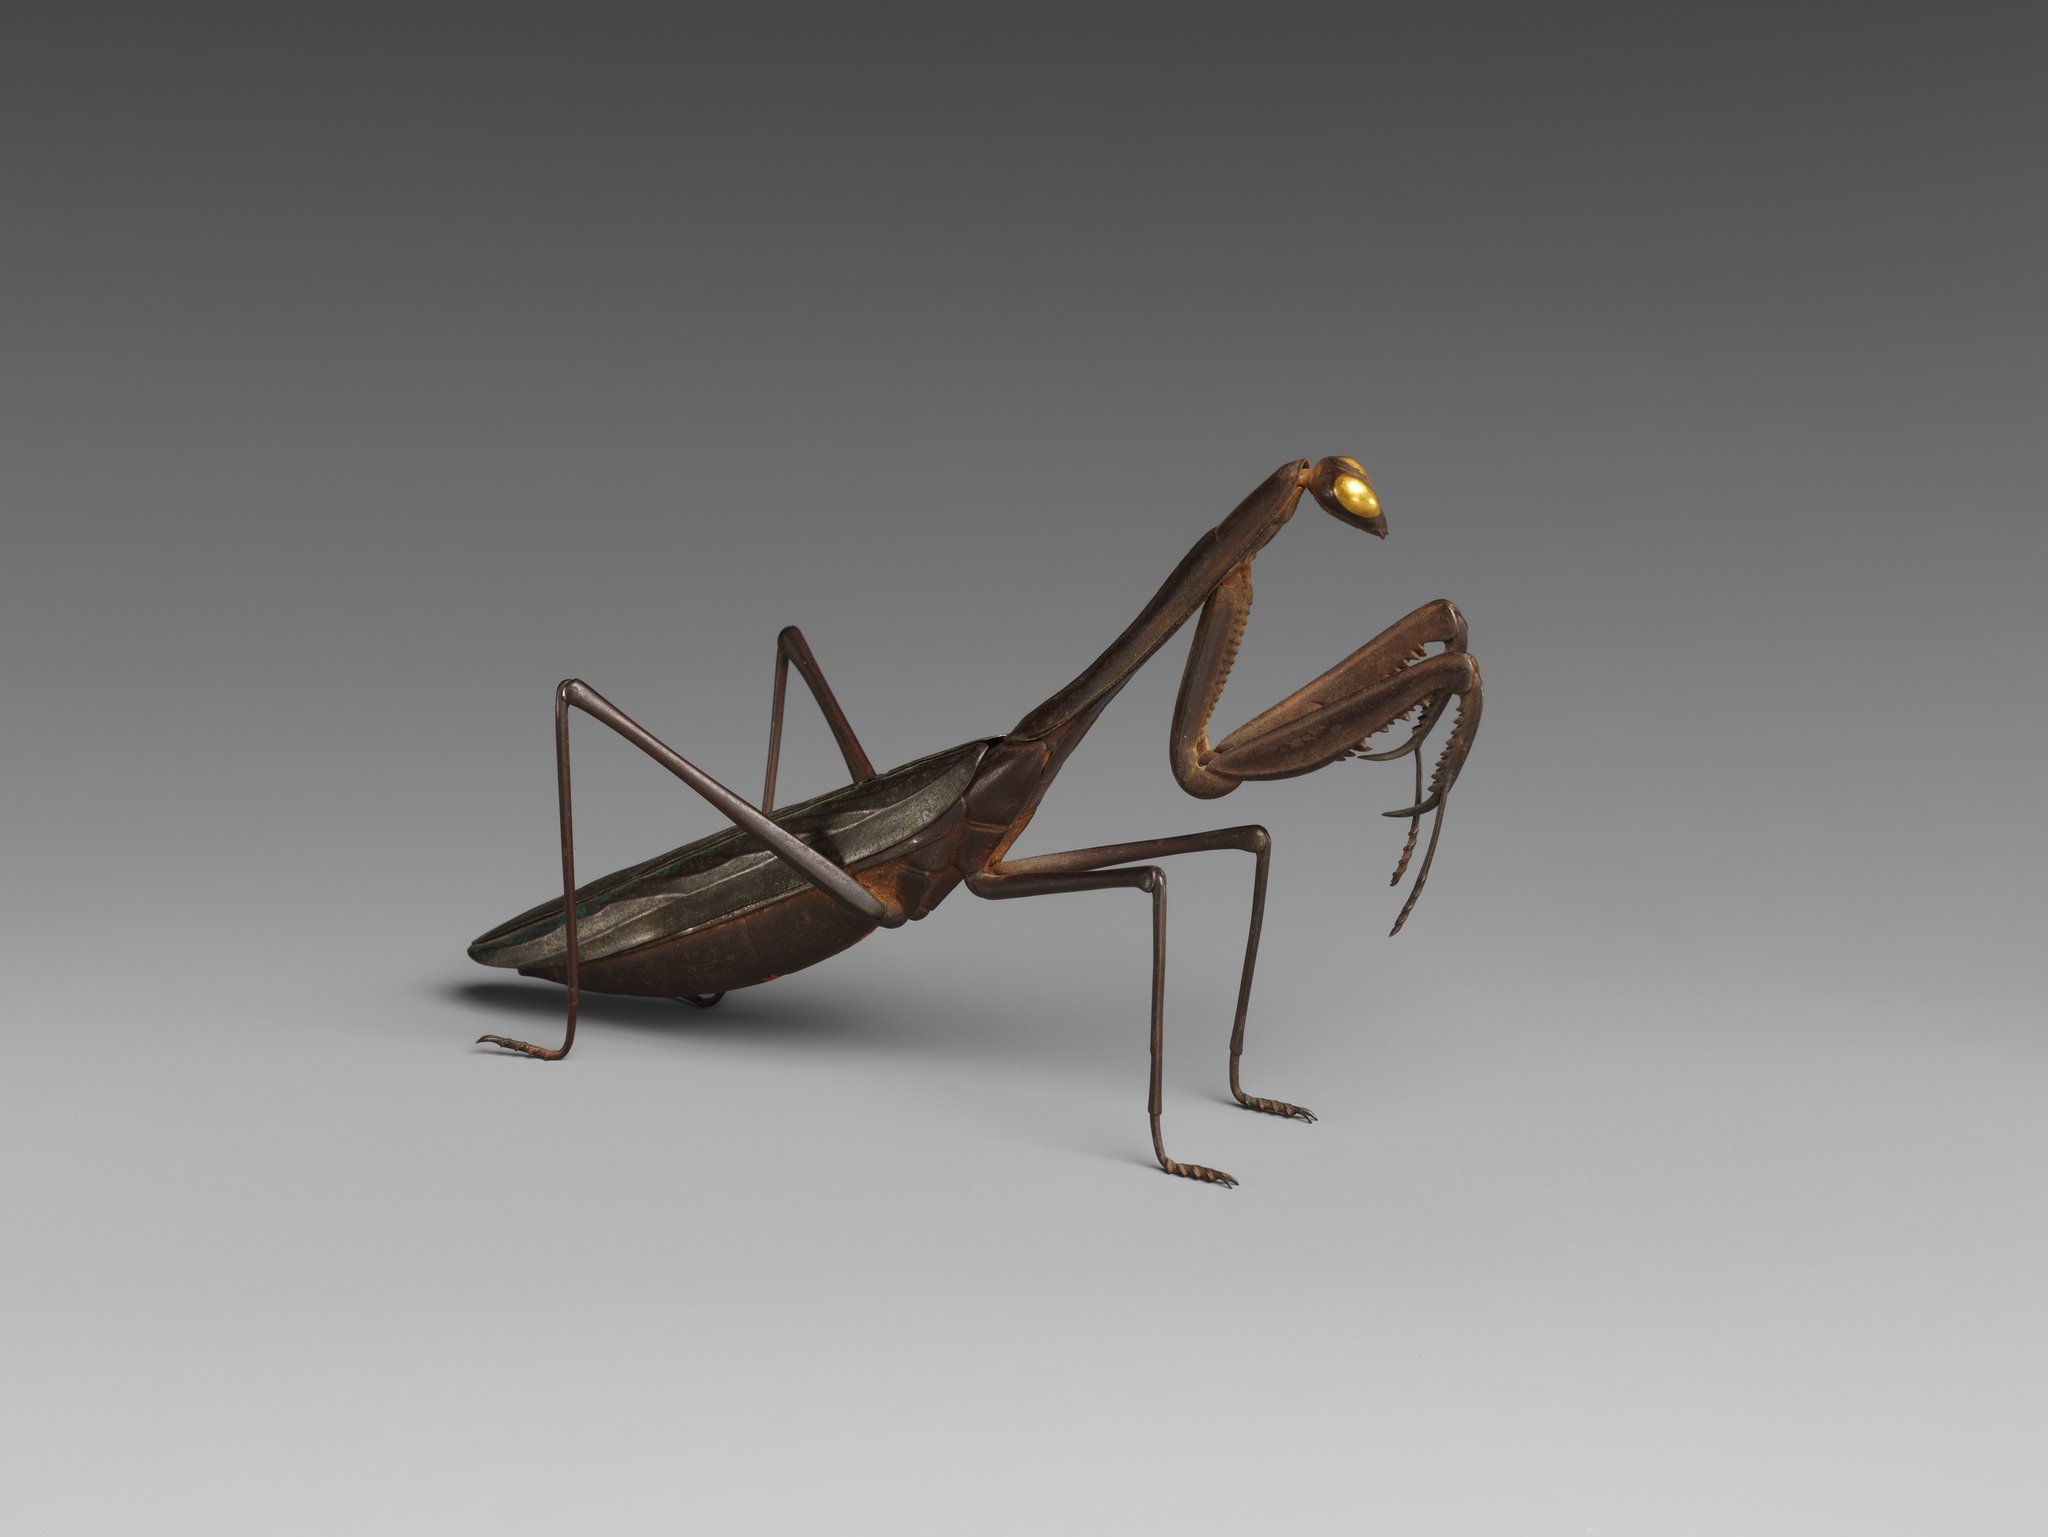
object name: incense burner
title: Incense Burner in Form of a Praying Mantis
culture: japanese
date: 1801-1900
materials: gold, iron, silver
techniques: lining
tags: insects